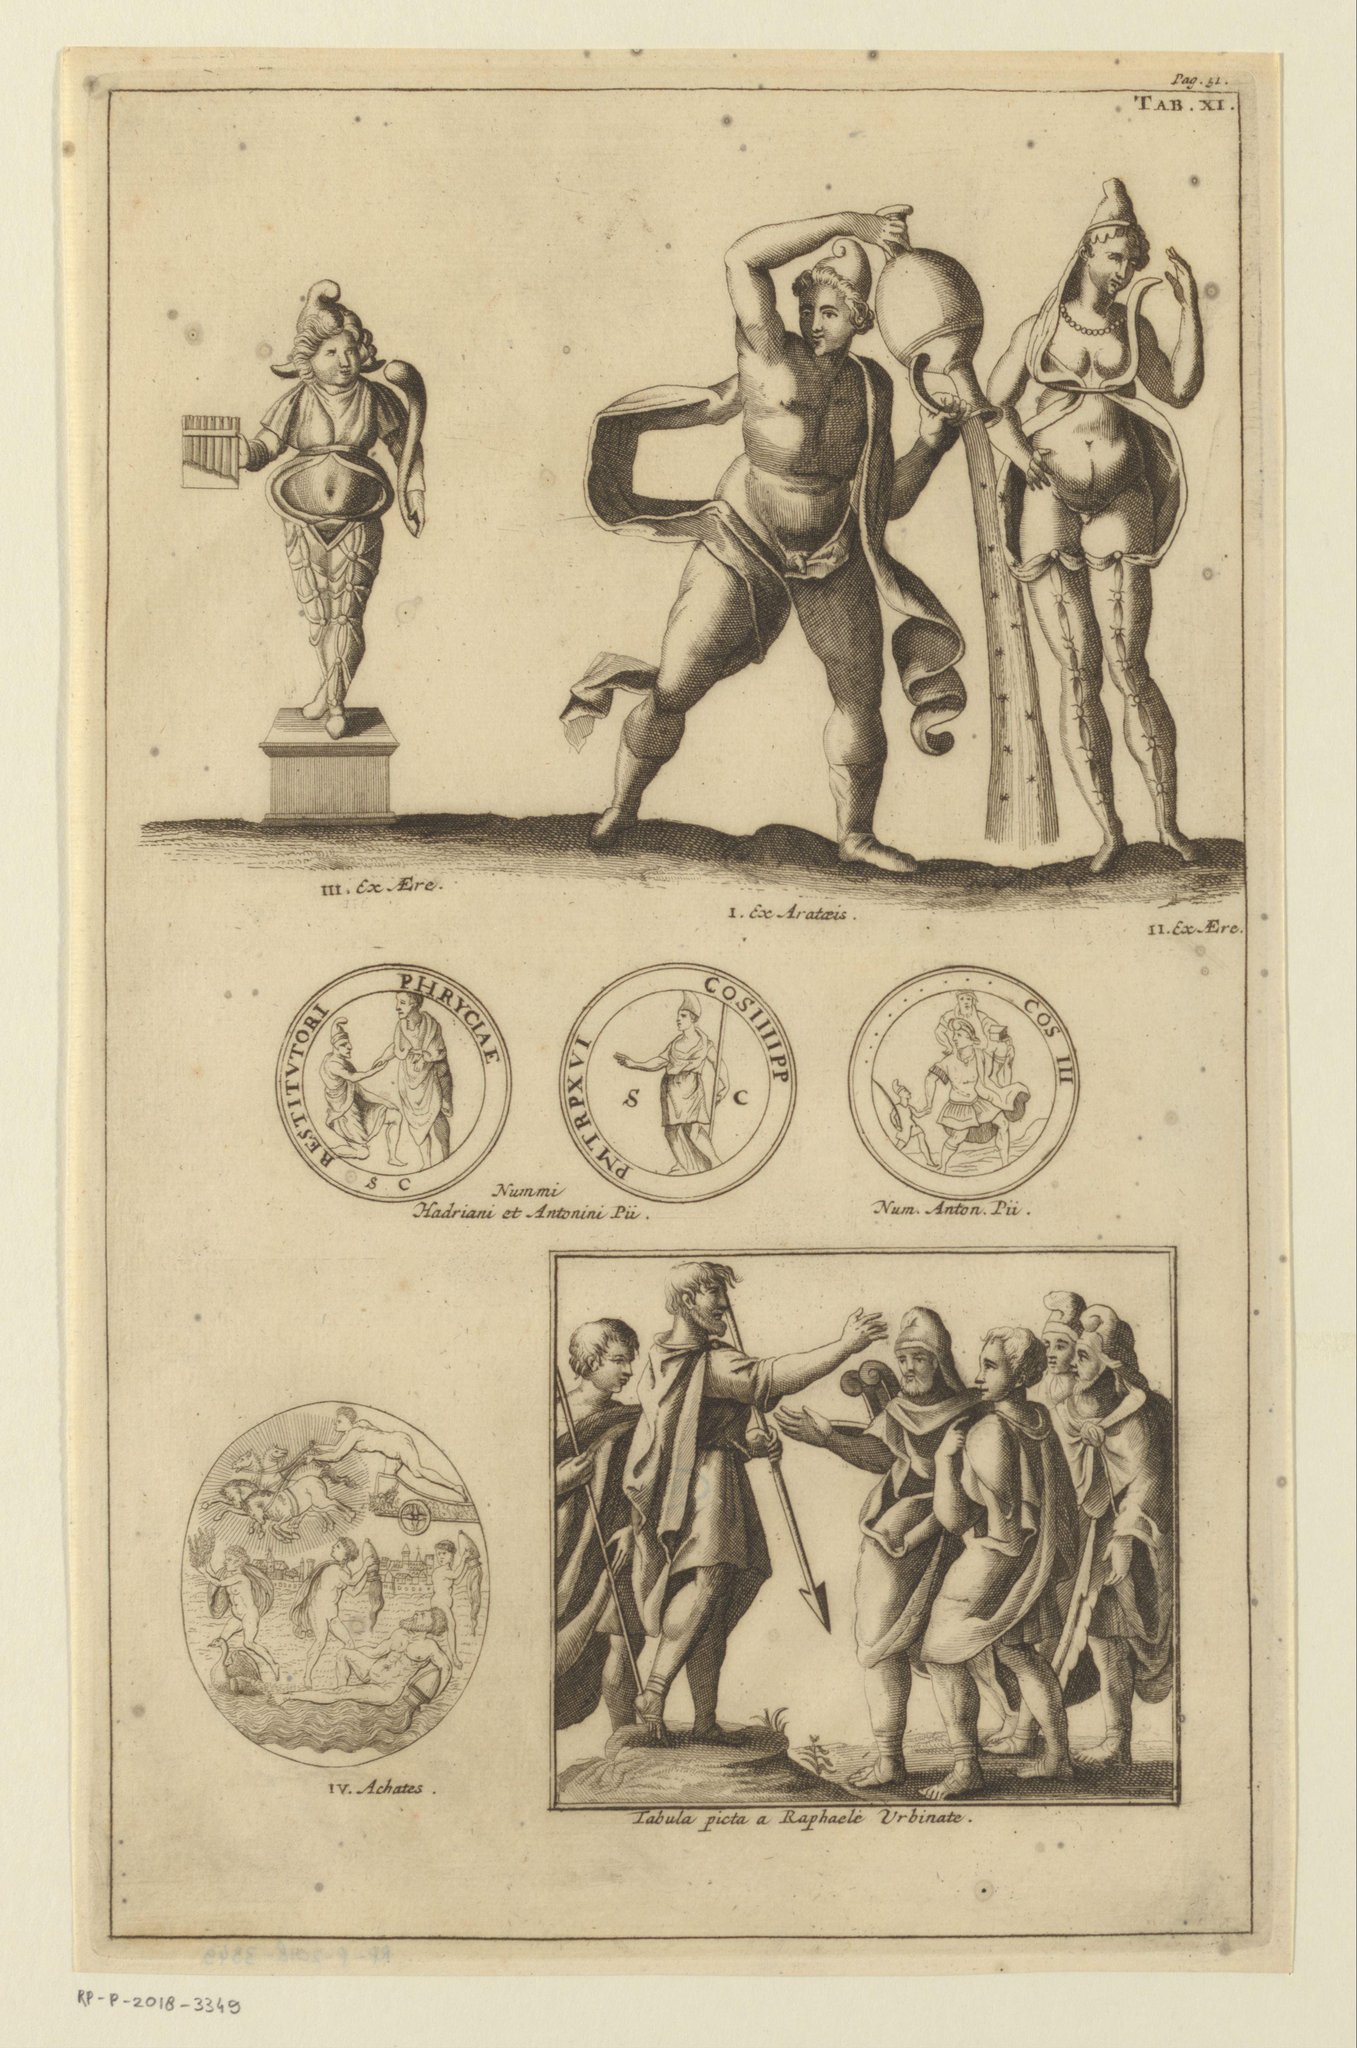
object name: print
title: Compositie met munten, een camee, een schilderij en drie beelden van Pan, het sterrenbeeld Waterman en een vrouw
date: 1700-1799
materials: paper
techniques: engraving, etching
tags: coin, sculpture, aquarius (zodiacal sign of january)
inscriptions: collector's mark: Lugt 2228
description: Prent uit een onbekend boek met objecten, kunstwerken en figuren uit de Romeinse geschiedenis en religie. Dit betreft een illustratie bij p. 51.